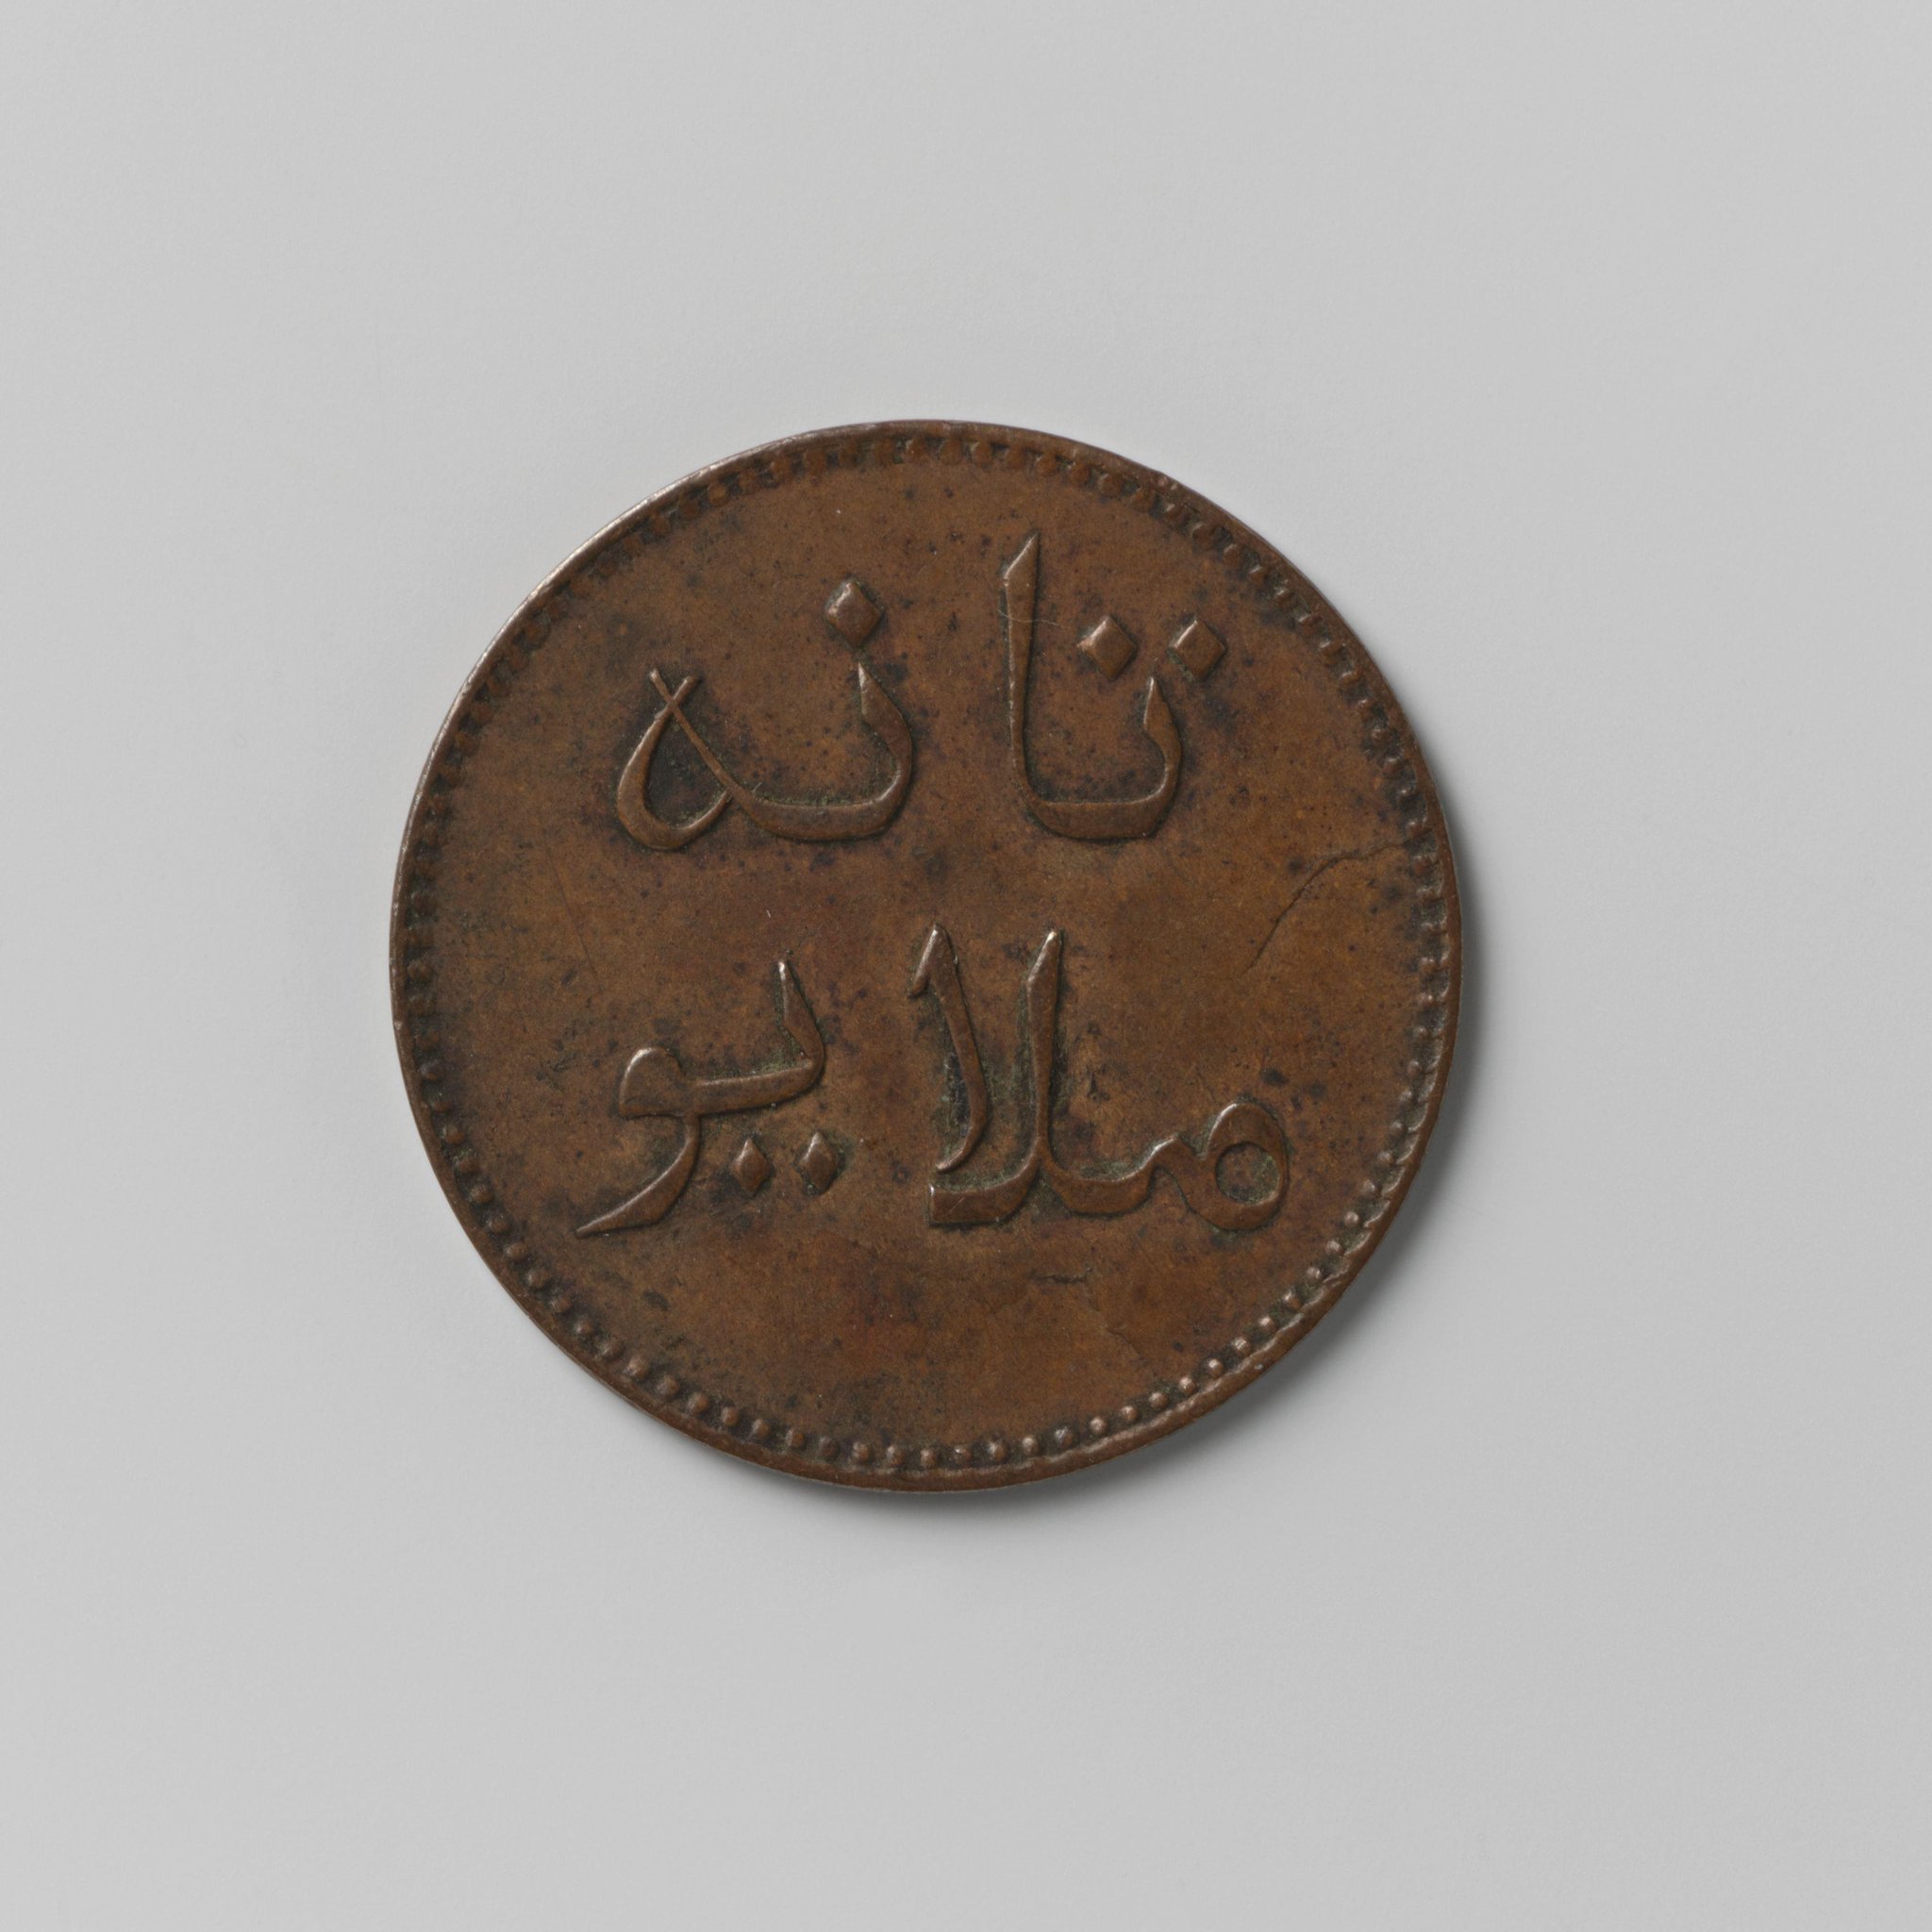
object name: coin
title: Kepeng voor Malakka en Sumatra, 1835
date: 1835-1836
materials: copper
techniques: striking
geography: birmingham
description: Koperen munt. Particuliere munt. Voorzijde: tweeregelig opschrift: aanduiding in het Maleis in Arabische lettertekens: Land van de Maleiers, waarboven en waaronder zon. Keerzijde: eenregelig Maleis opschrift in Arabische lettertekens: een kepeng, waarboven waarde-aanduiding 1 en waaronder het jaartal 1251 in Islamitische tijdsrekening. Gladde rand.